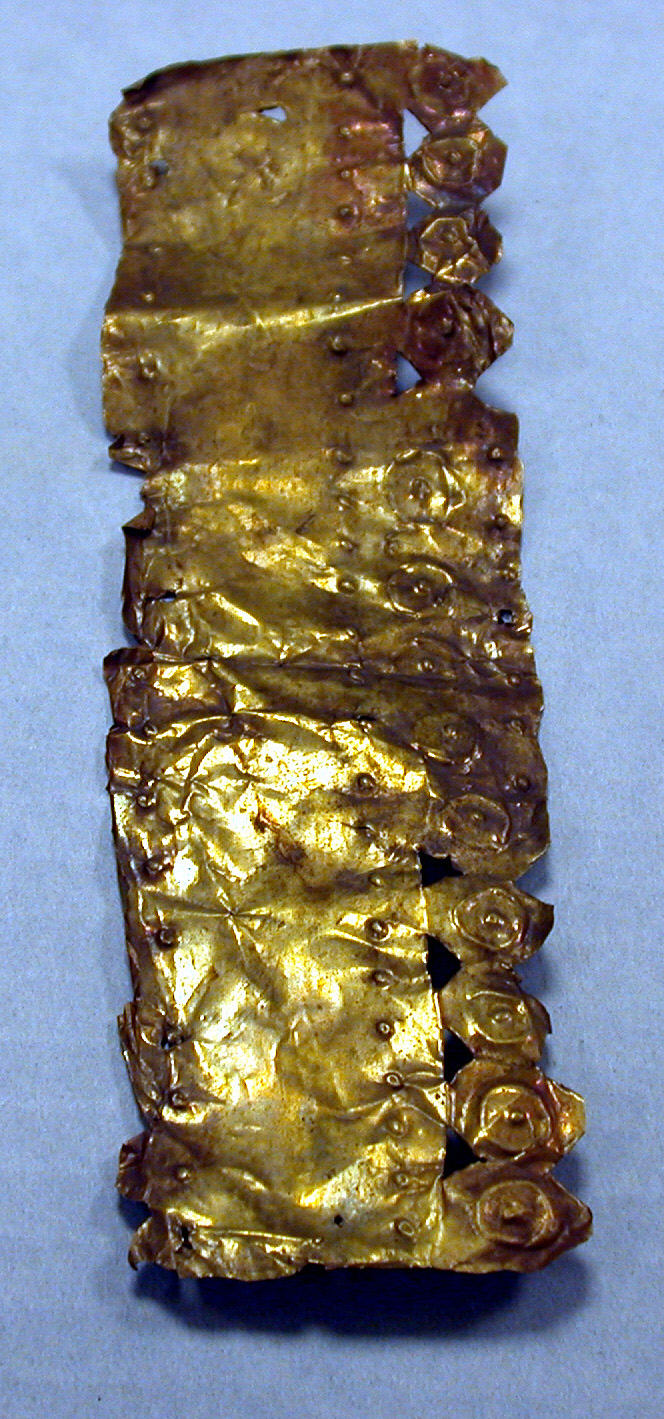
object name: ornament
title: Gold Sheet Ornament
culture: peruvian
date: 200-900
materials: gold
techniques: hammering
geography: peru